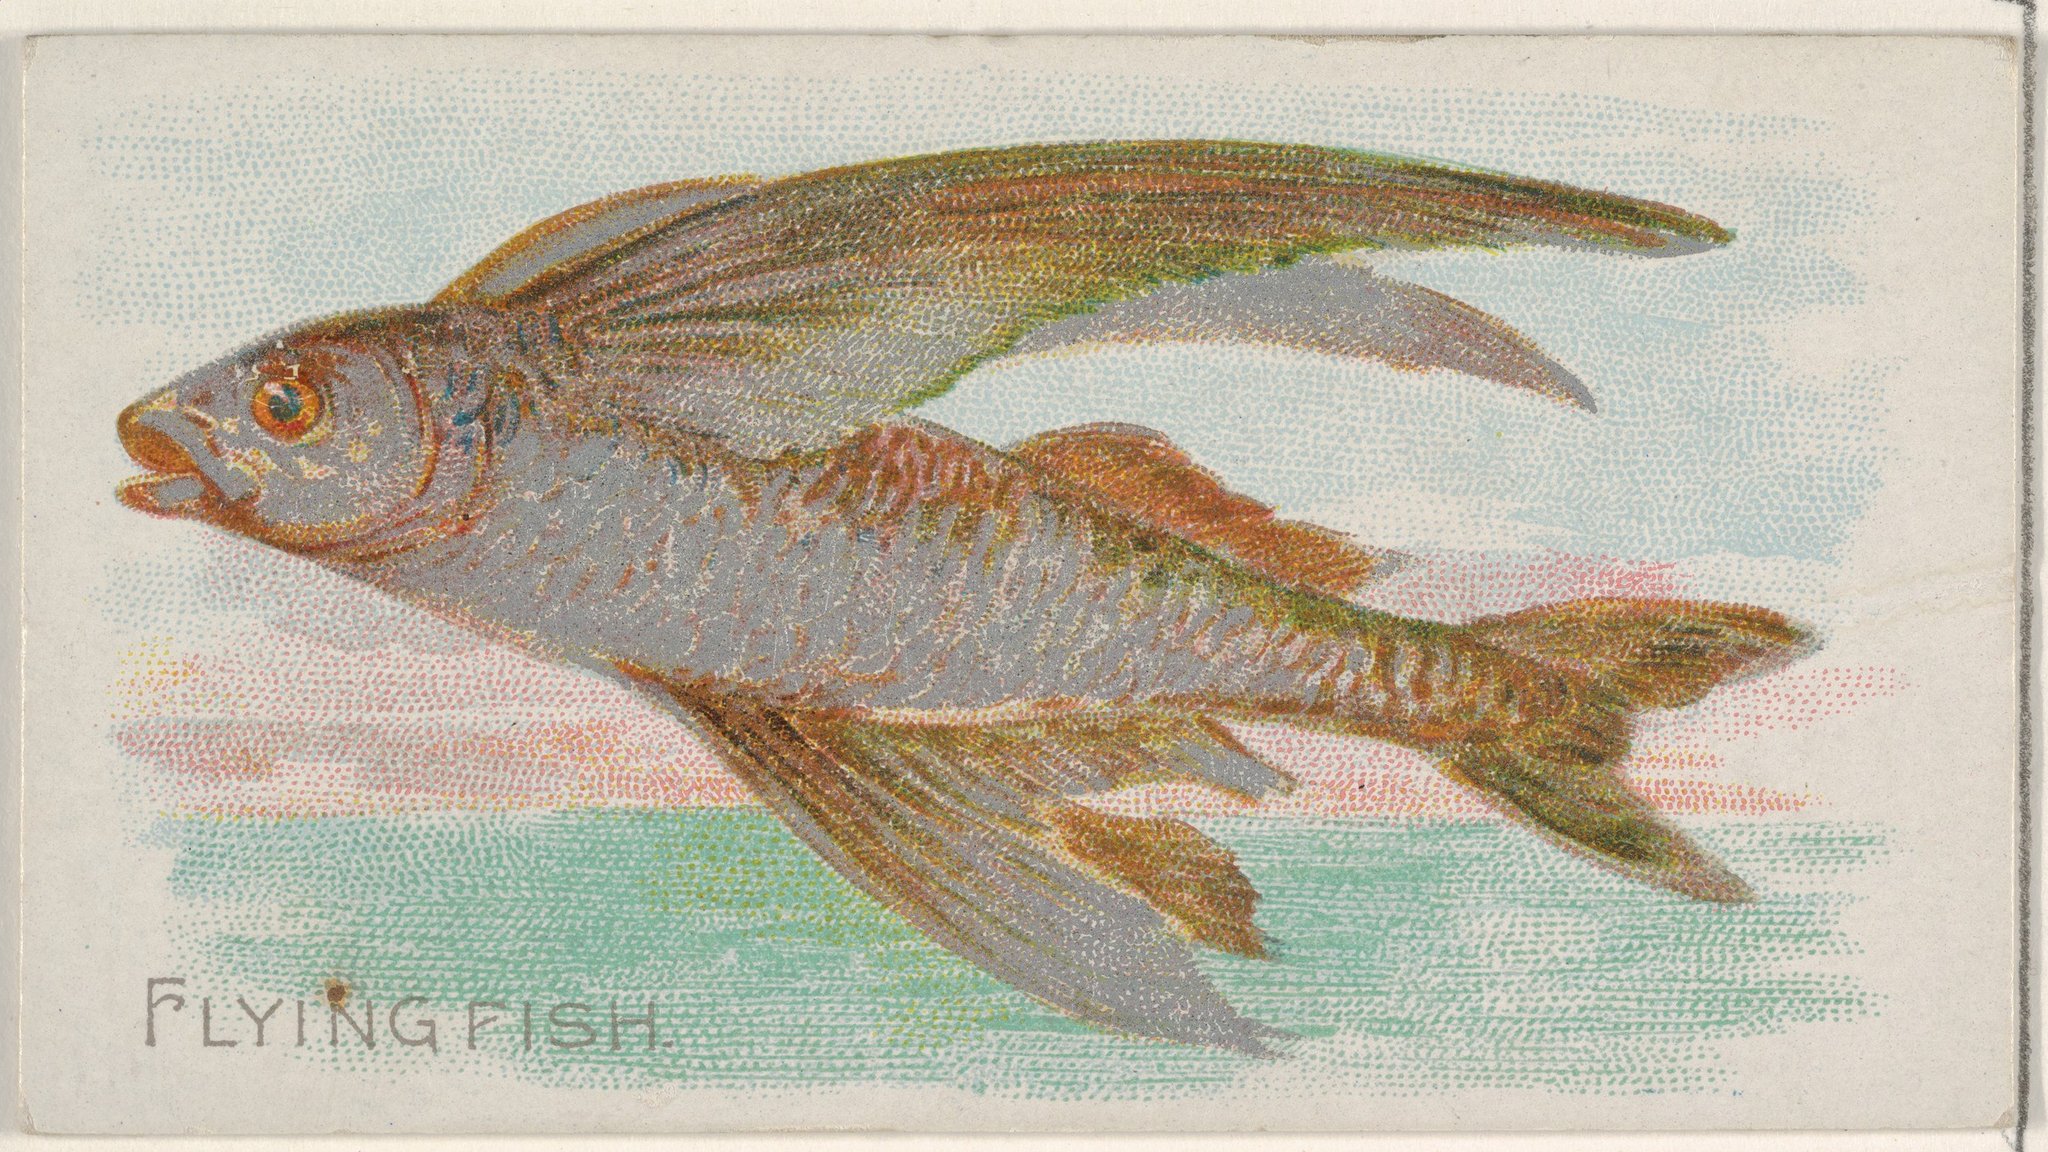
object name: print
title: Flying Fish, from the Fish from American Waters series (N8) for Allen & Ginter Cigarettes Brands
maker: allen & ginter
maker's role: publisher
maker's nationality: american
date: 1889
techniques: color lithograph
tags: fish